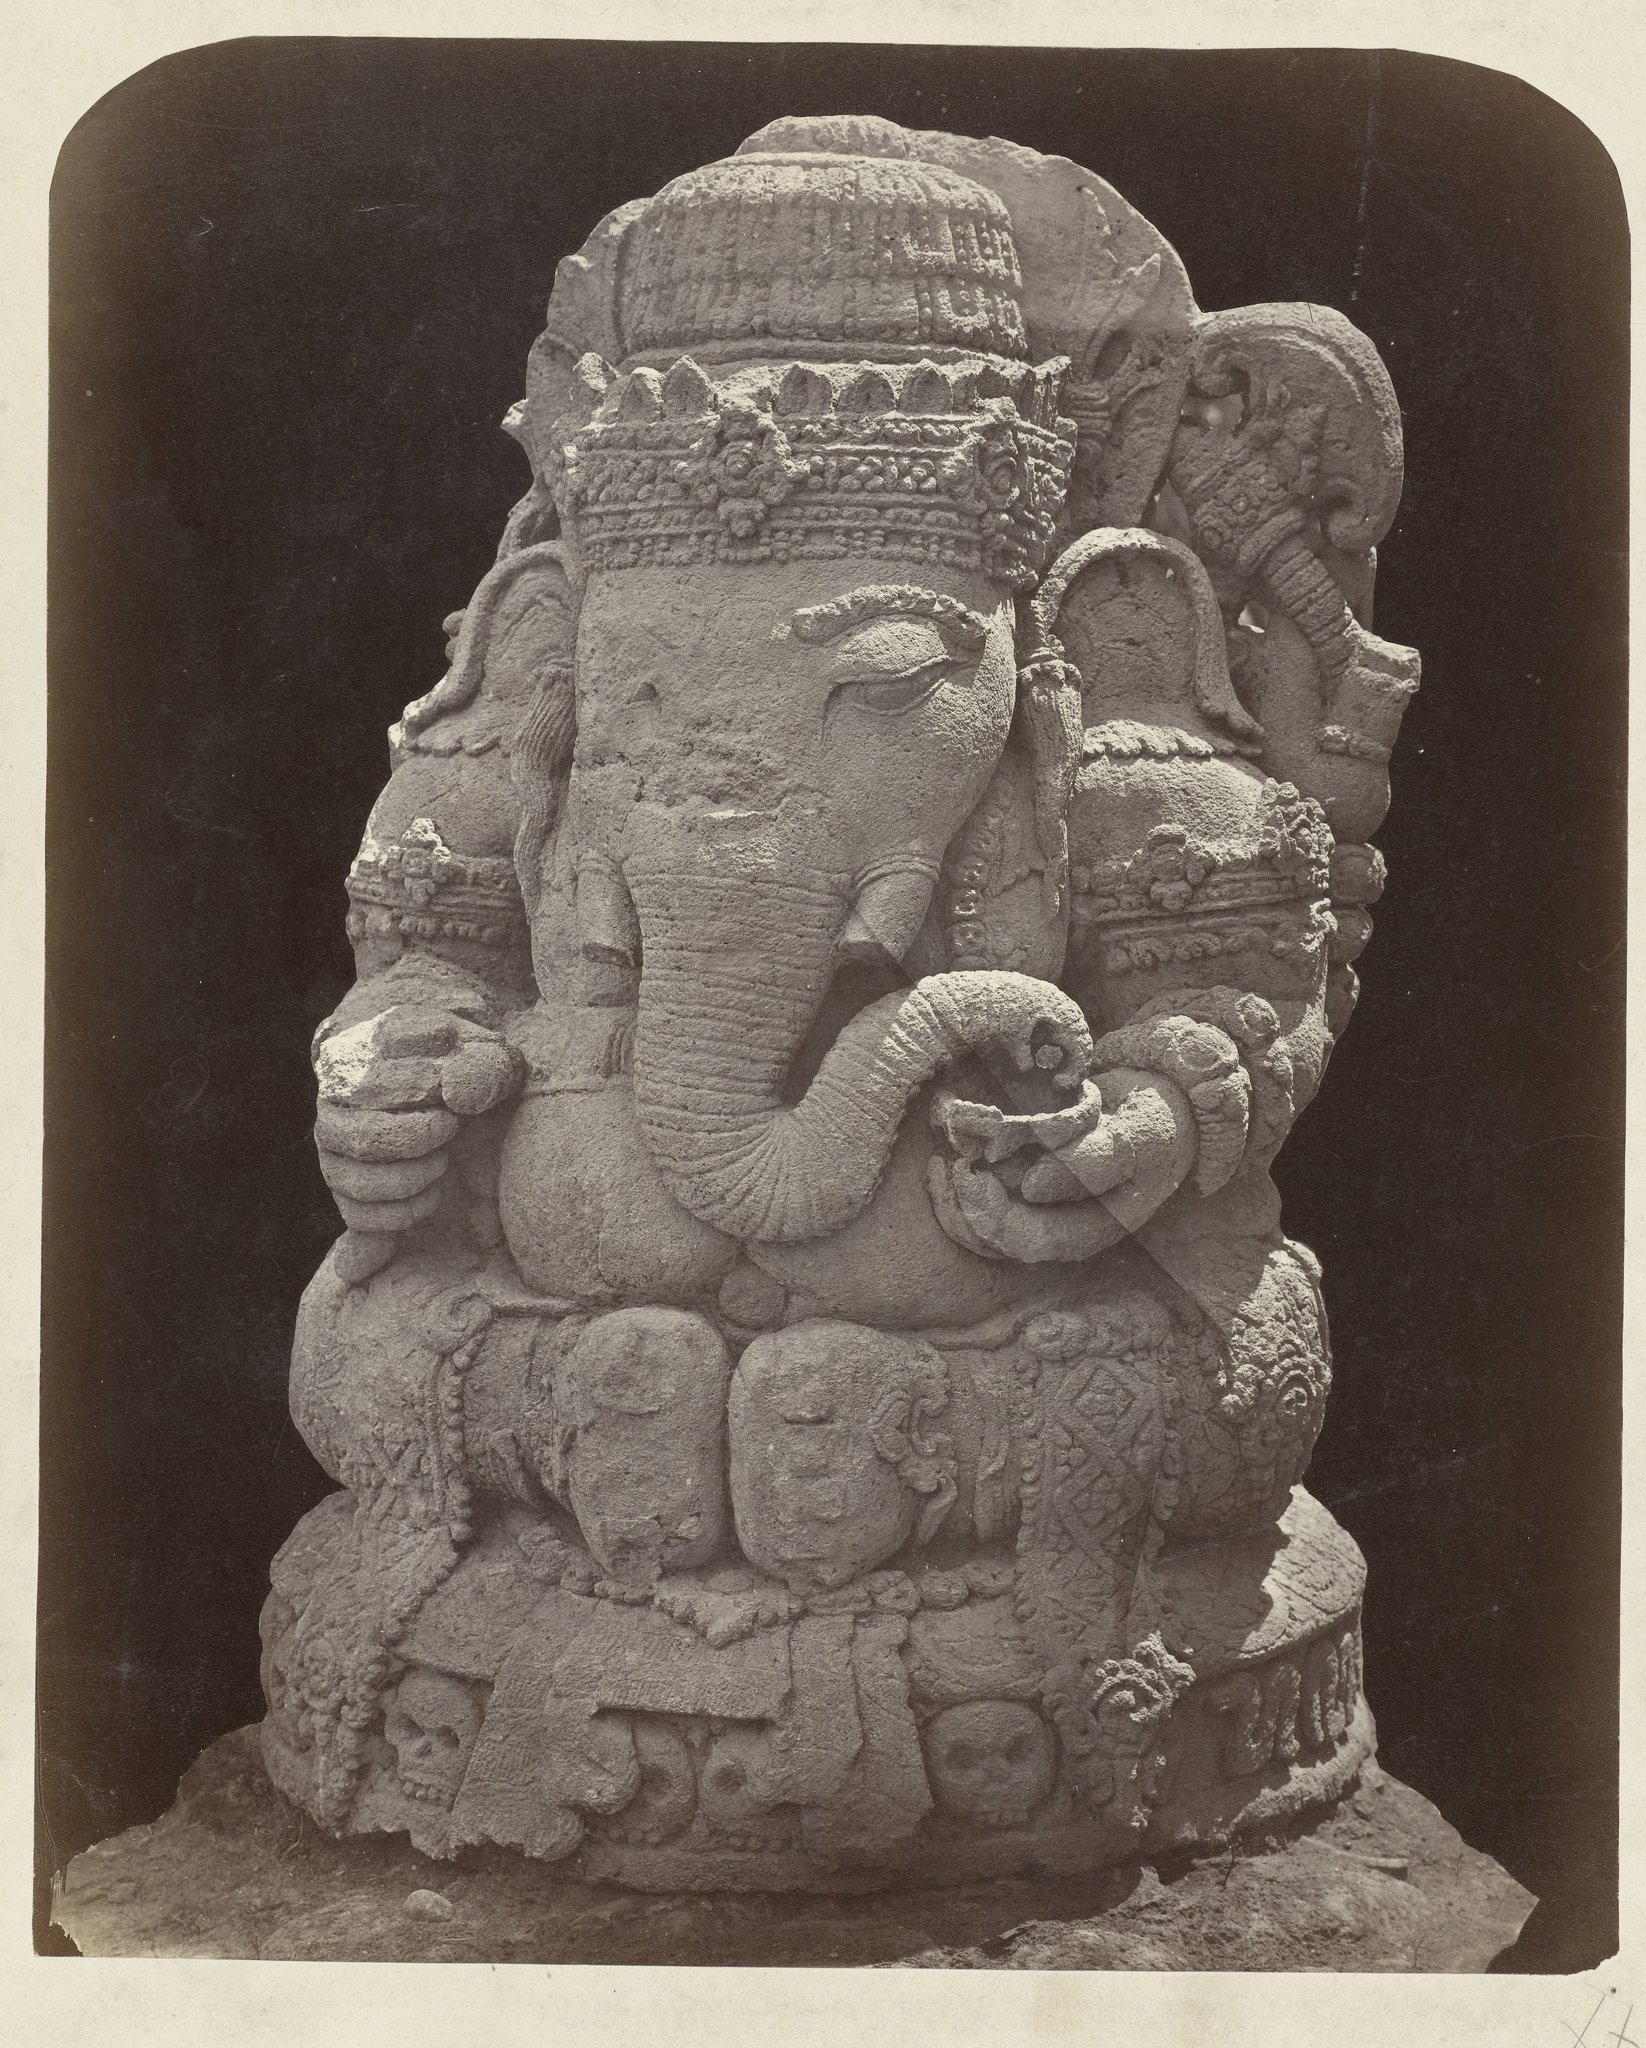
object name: photograph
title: Four-armed Ganesha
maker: isidore kinsbergen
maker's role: fotograaf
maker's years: 1821-1905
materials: cardboard, paper, photographic support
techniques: albumen print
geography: java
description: Kinsbergen not only photographed temples and other historical buildings, but also took close-ups of sculptures. This Hindu statue of the god Ganesha with an elephant’s head was found near Blitar on East Java. The god eats from a skull, and the base on which he sits is also surrounded by skulls. This expresses his power over death.